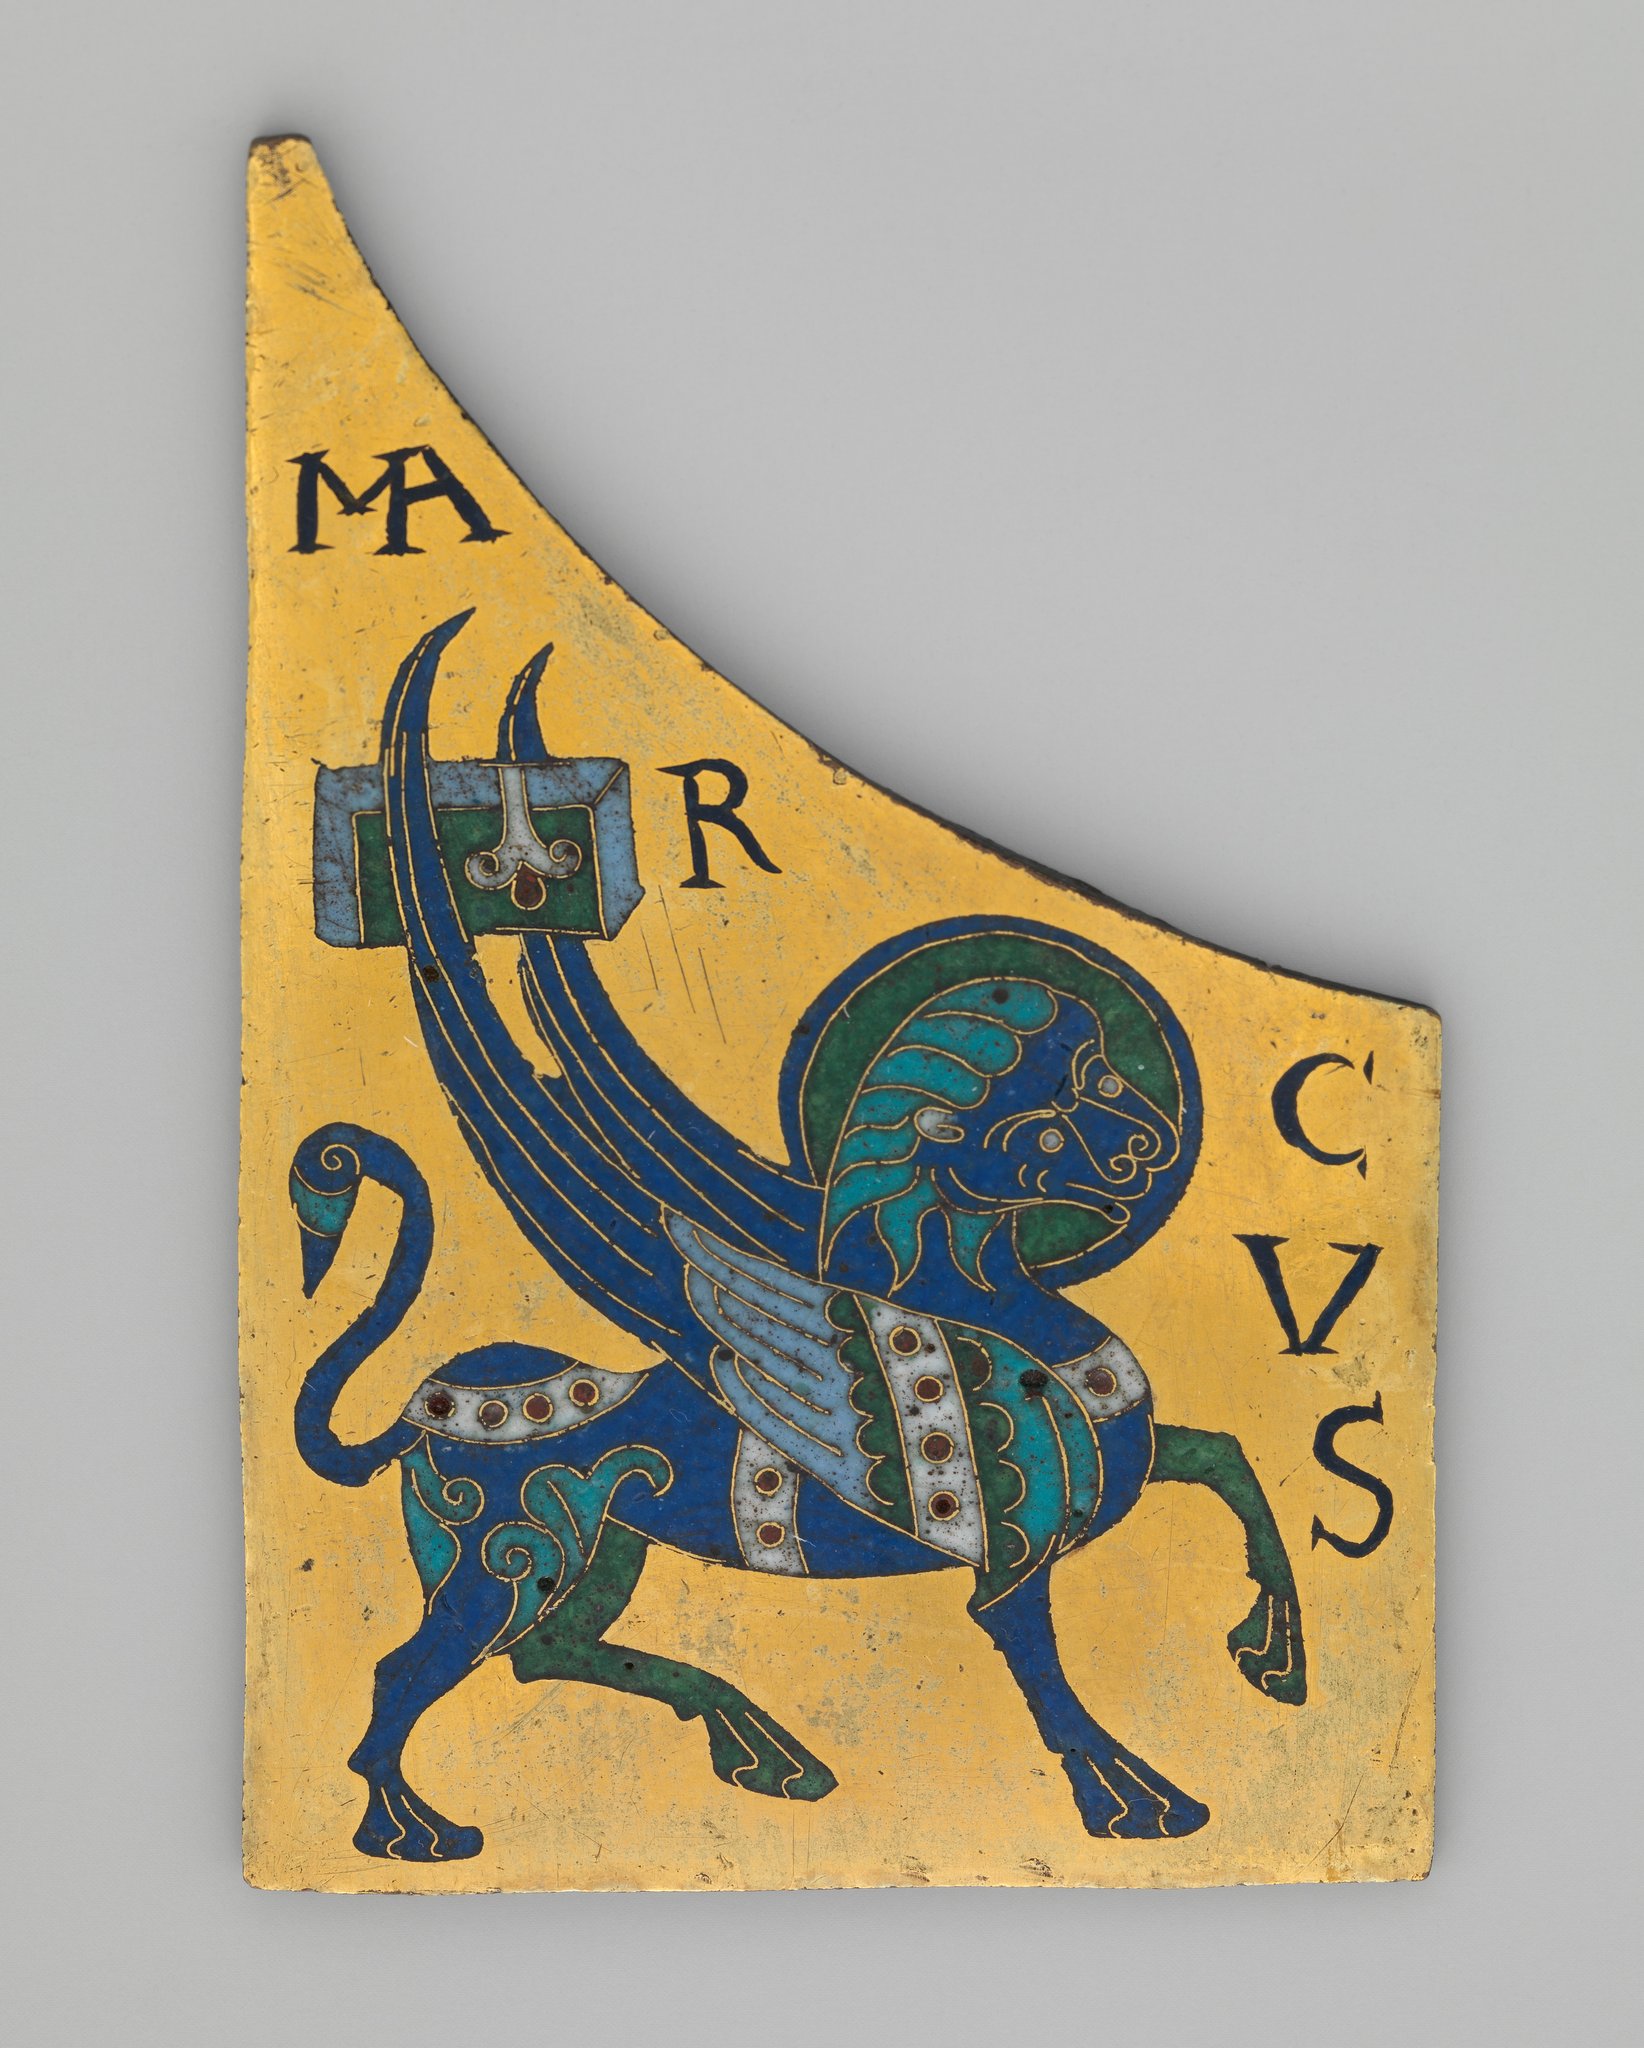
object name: plaque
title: Plaque with the Symbol of the Evangelist Mark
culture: french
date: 1100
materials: copper, enamel, gilt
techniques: enamel, cutting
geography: france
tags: emblems